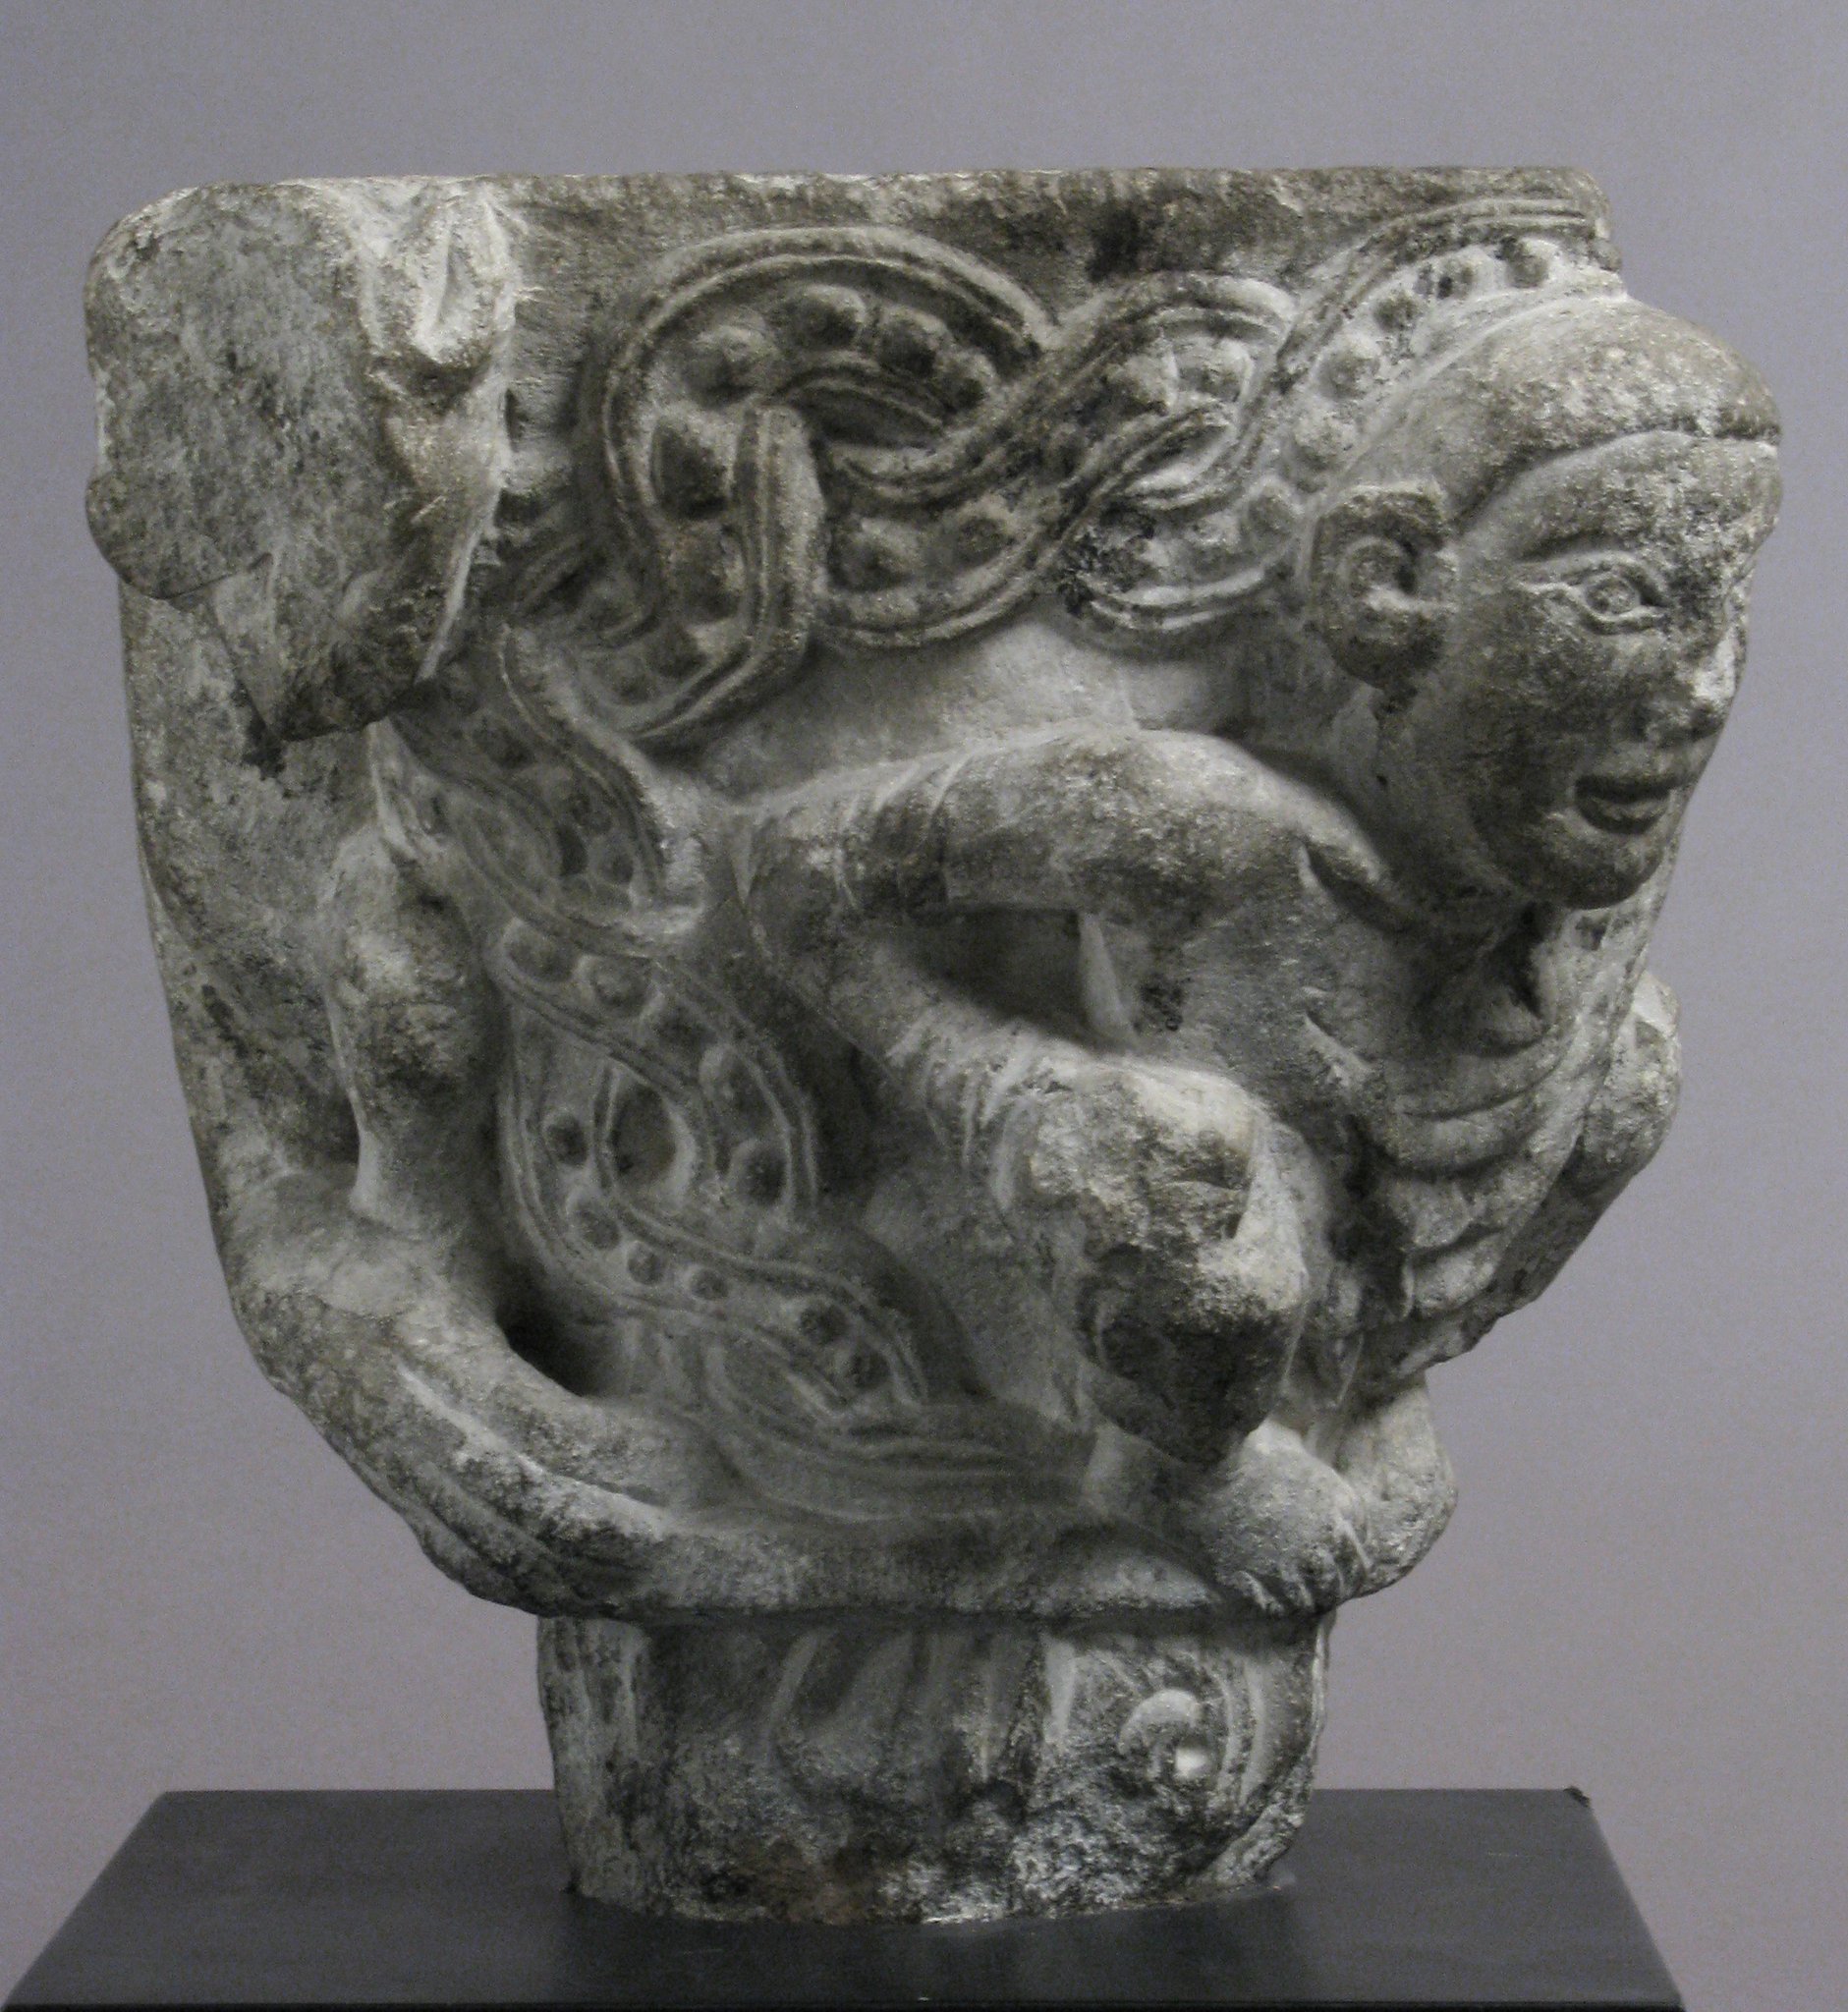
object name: capital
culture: spanish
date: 1101-1200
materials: stone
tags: human figures